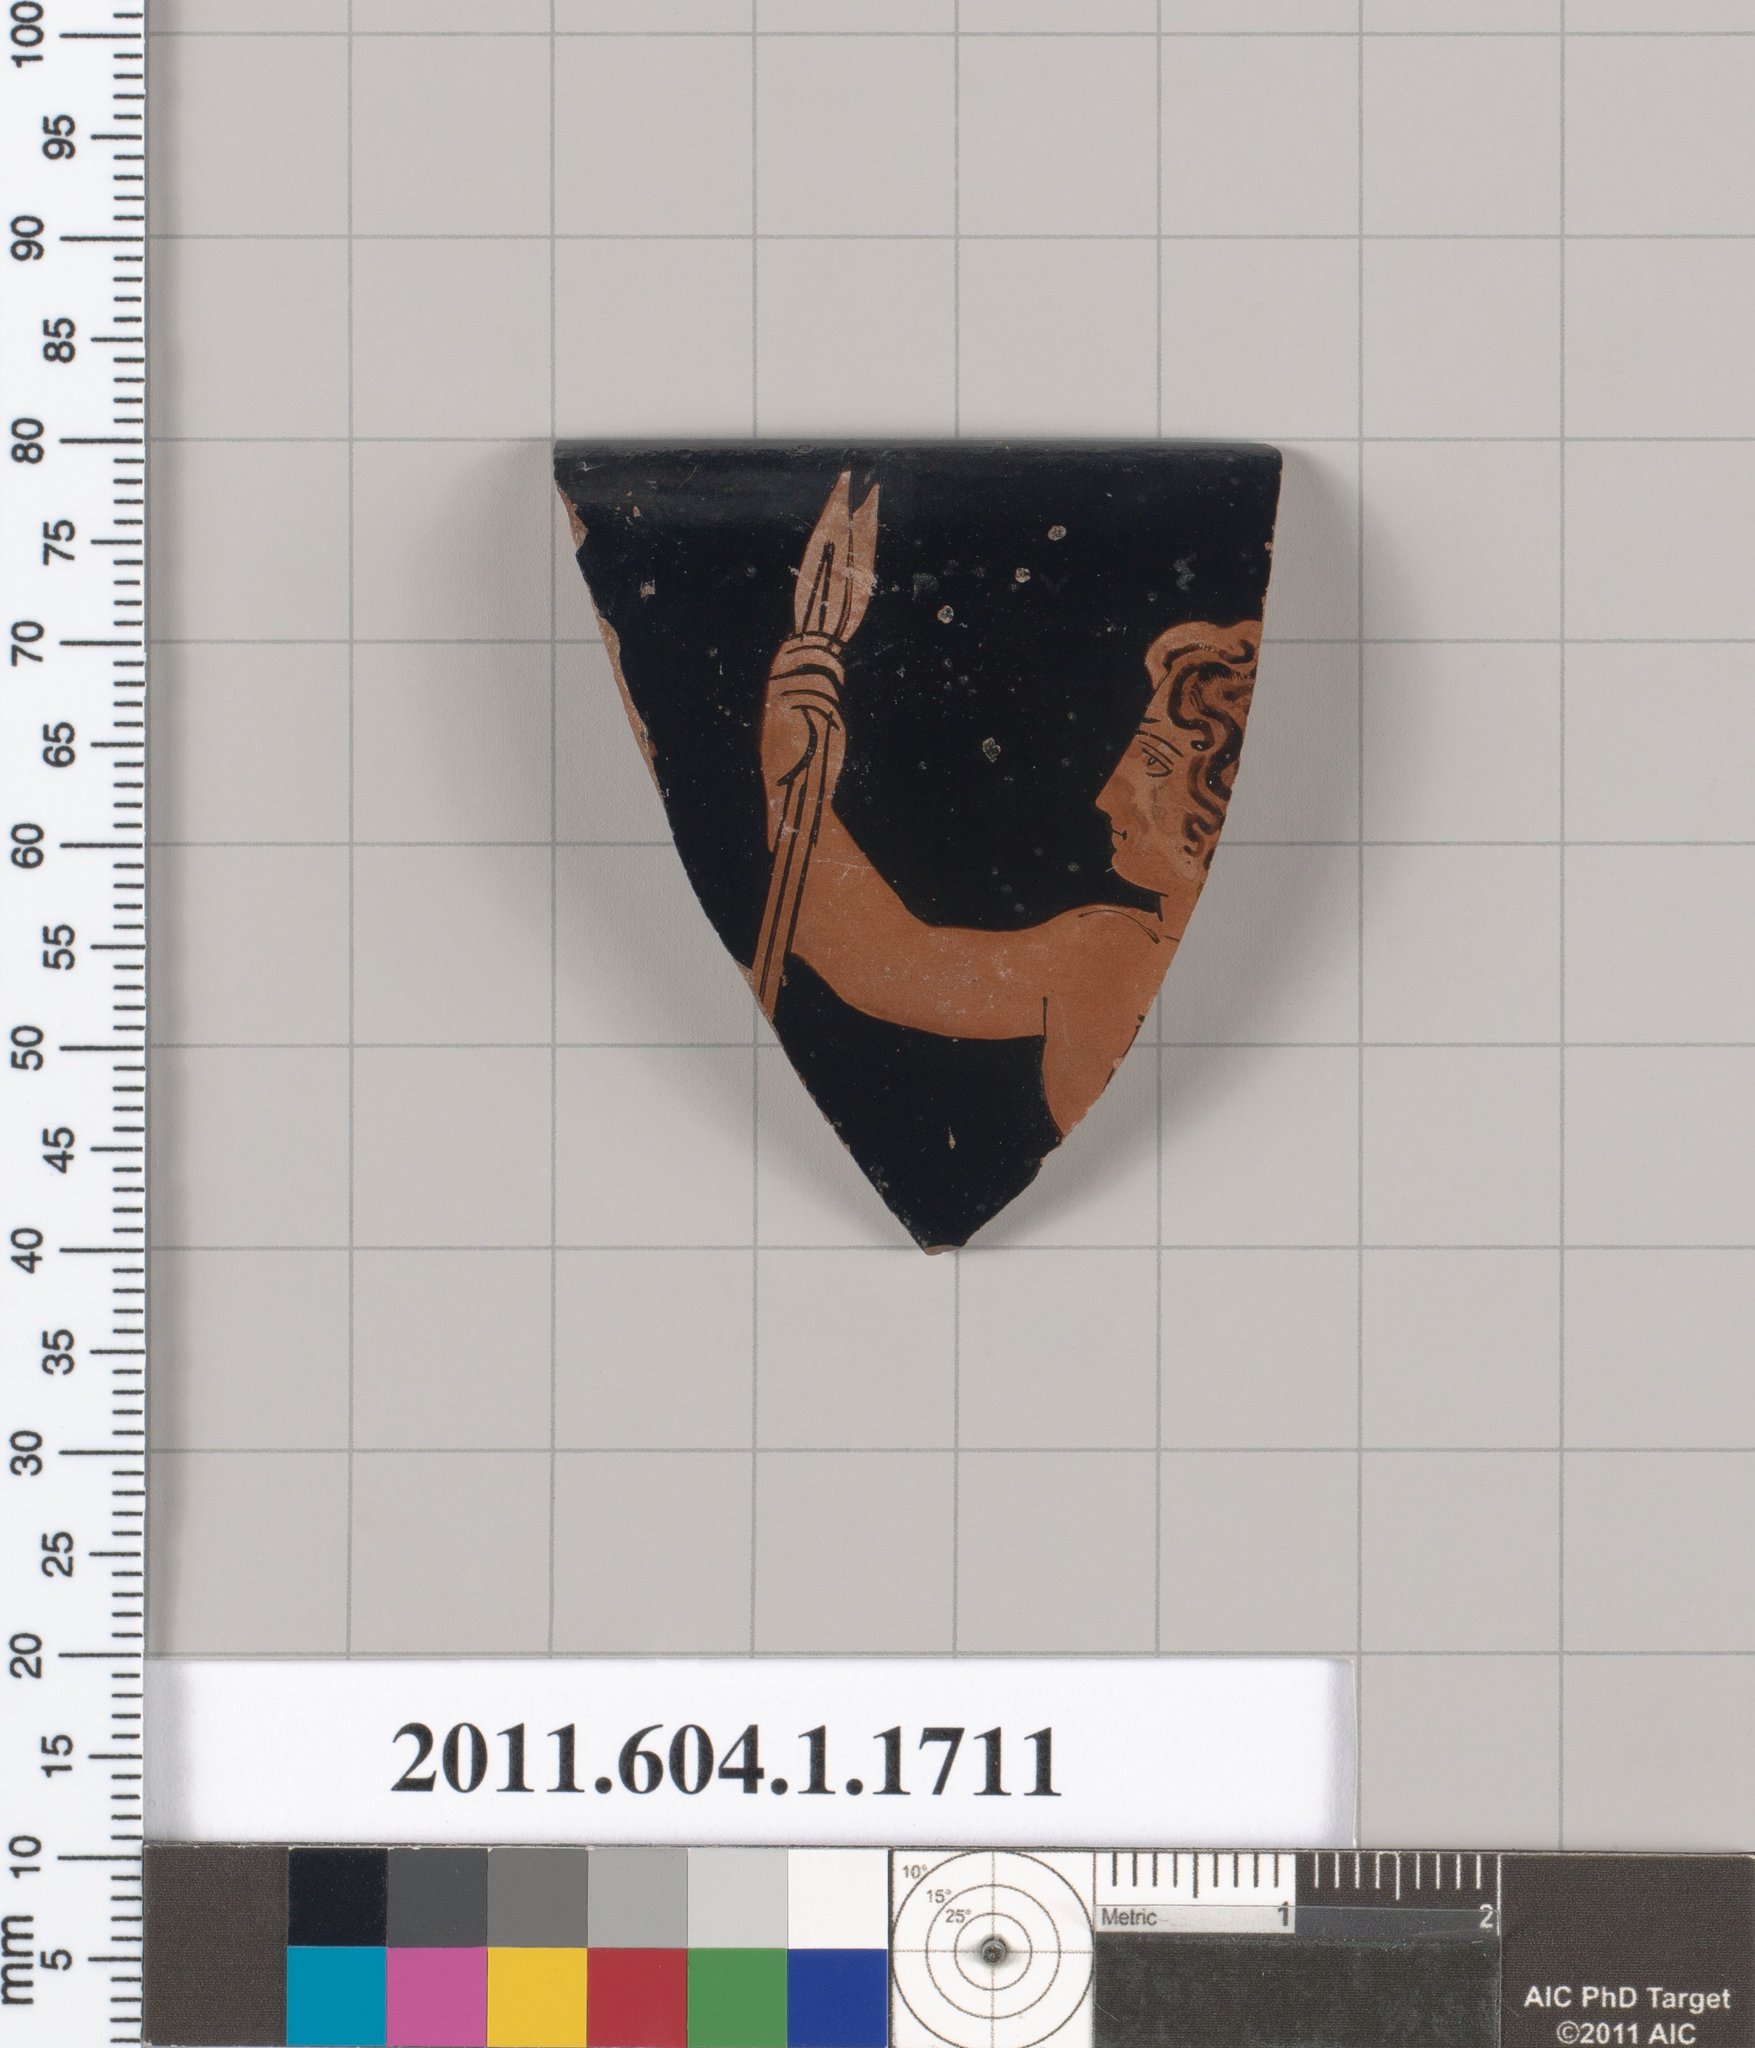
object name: kylix fragment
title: Terracotta rim fragment of a kylix (drinking cup)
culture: greek, attic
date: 467-435 BCE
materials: terracotta